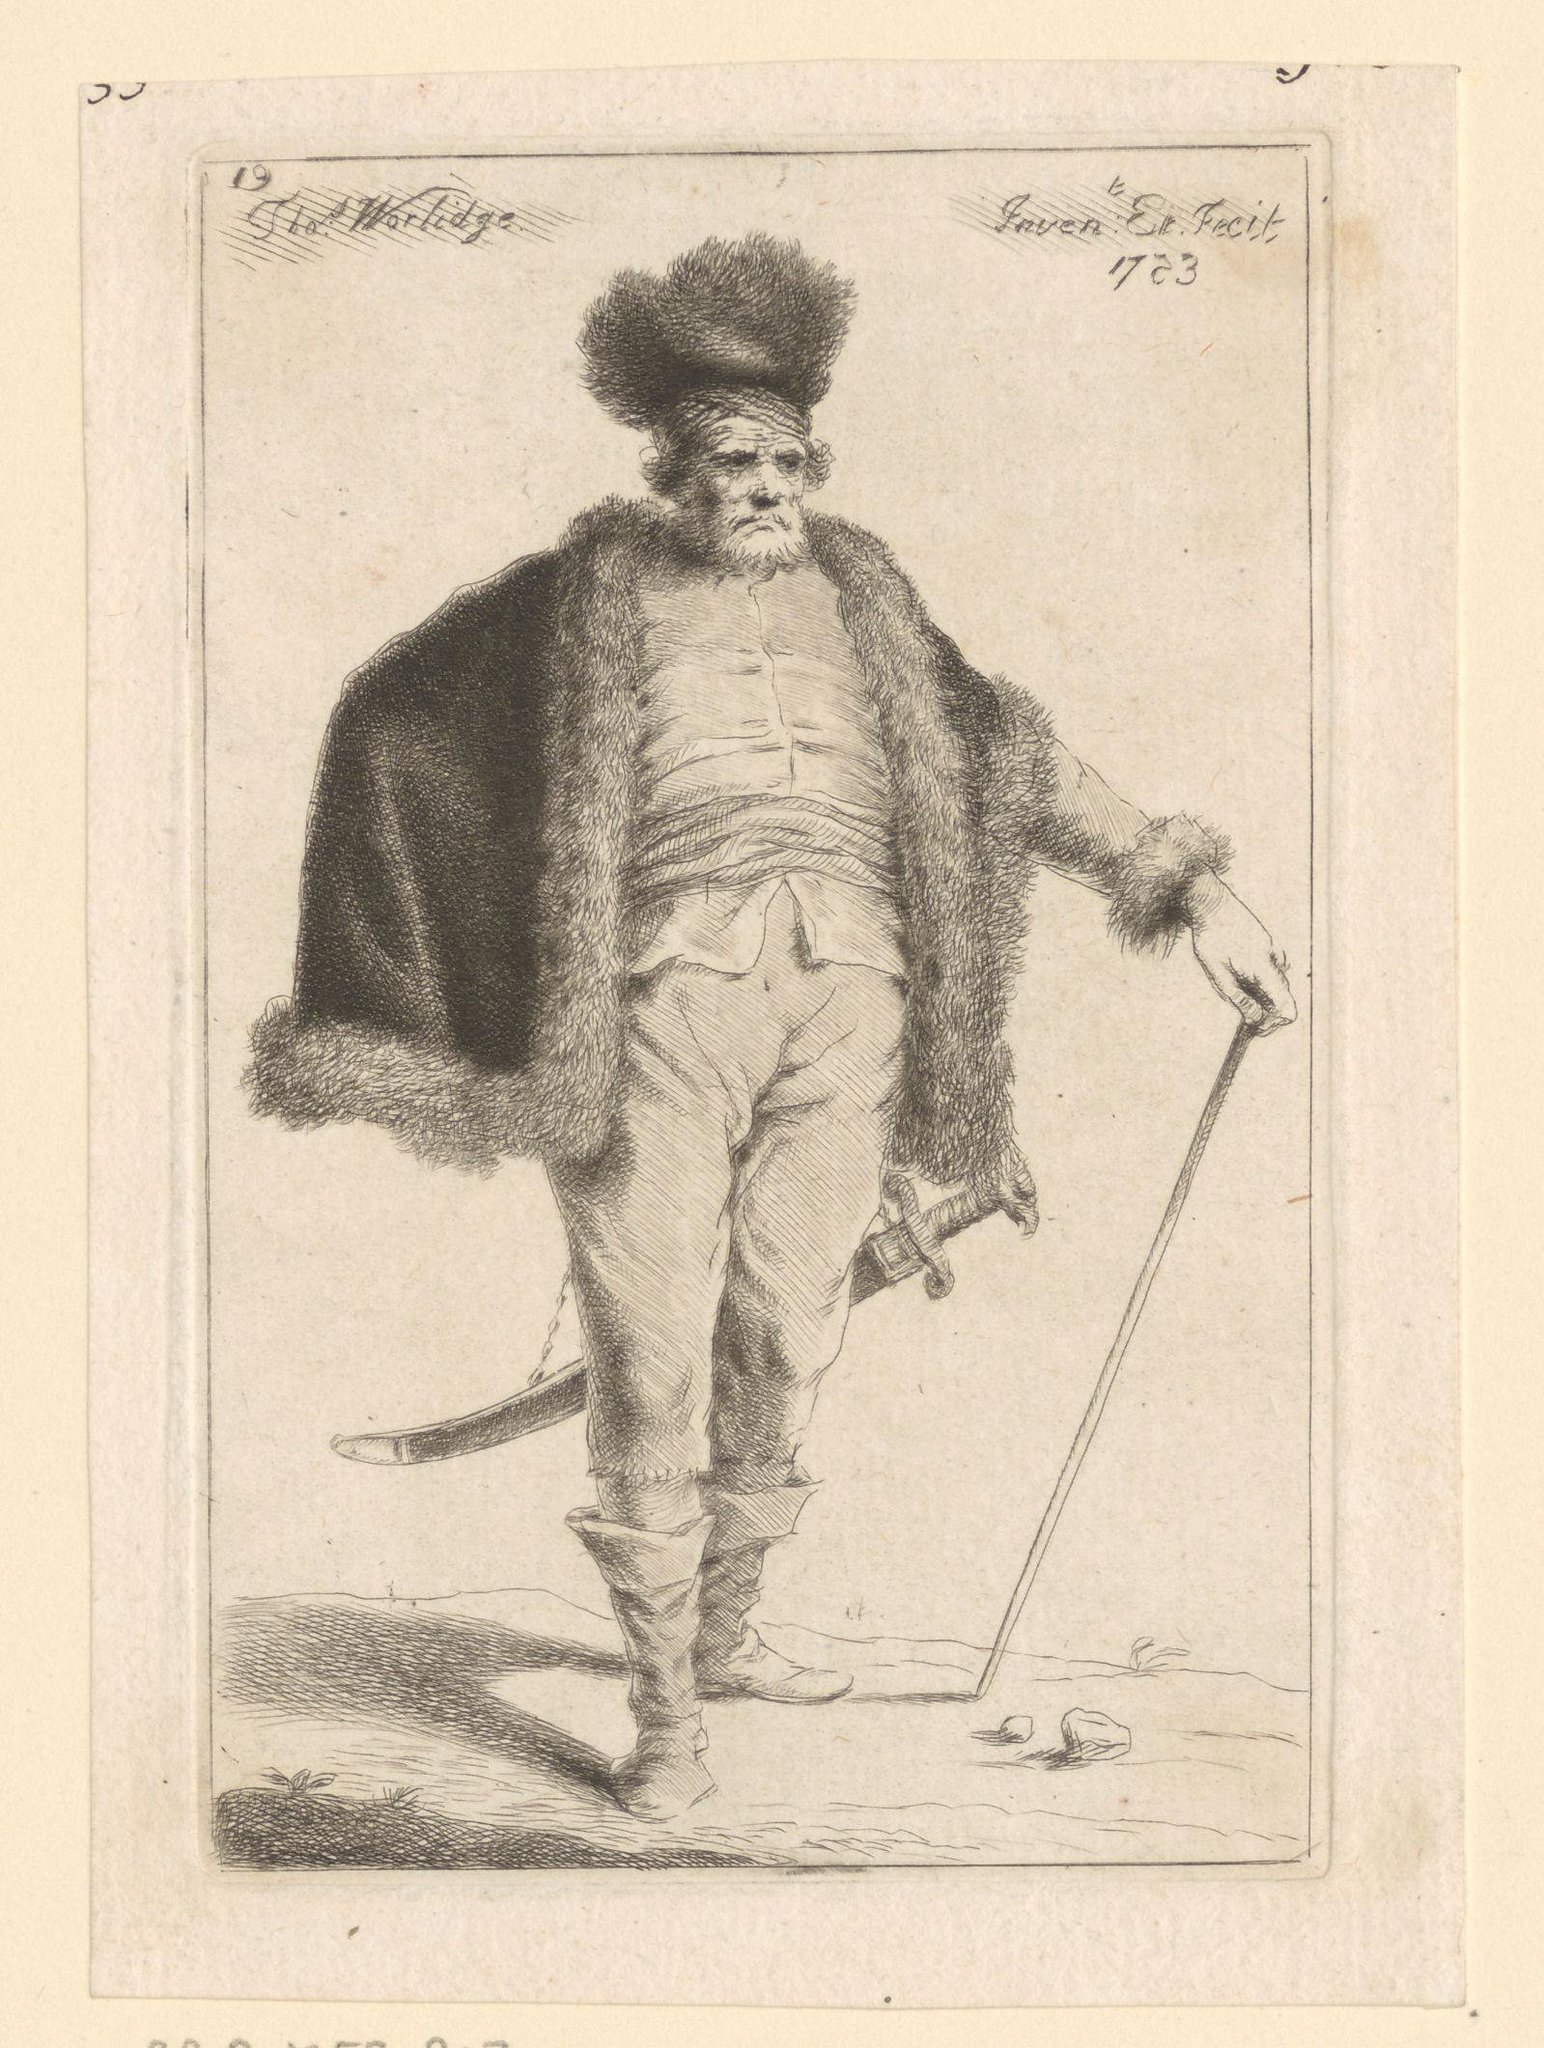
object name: print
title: Staande man met bontmuts, bontjas en zwaard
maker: thomas worlidge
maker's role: print maker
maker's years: 1700-1766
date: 1753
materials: paper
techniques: drypoint, etching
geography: london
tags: head-gear (with name), walking-stick, staff, hacking and thrusting weapons: sword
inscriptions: collector's mark: Lugt 2760, collector's mark: Lugt 2228